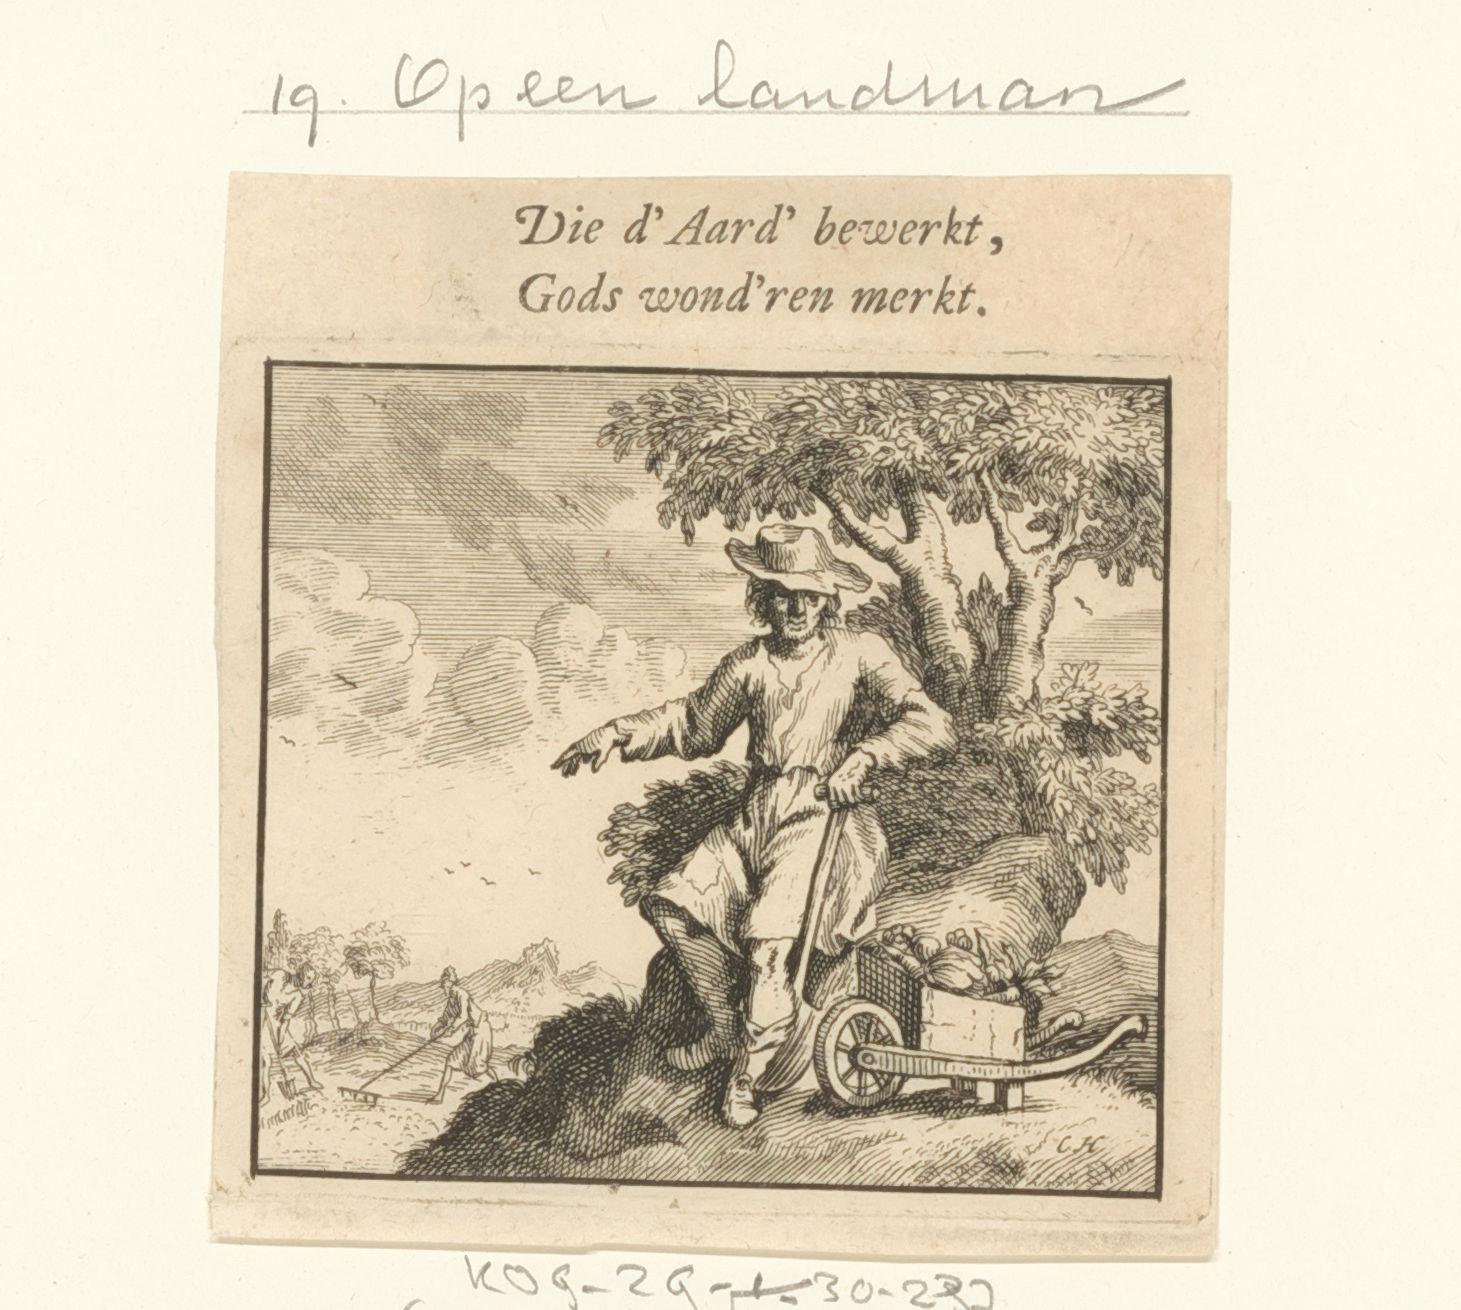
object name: print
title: Die d'Aard' bewerkt, Gods wond'ren merkt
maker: cornelis huyberts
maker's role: print maker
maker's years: 1669-1709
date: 1725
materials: paper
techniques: etching, letterpress printing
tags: agricultural implements: spade, wheelbarrow, spading ~ soil cultivation, agriculture, cattle-breeding, horticulture, flowerculture, etc.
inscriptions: stamp, collector's mark: Lugt 1641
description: Prent uit: Graauwhart, Hendrik. Voorbeeldelyke zeede-lessen, genoomen uyt den eersten toestand des werelds (...). Amsterdam: Johannes Ratelband, 1725. Prent ook gebruikt voor eerdere en (1709) latere uitgave (1756, 1761 en 1764).